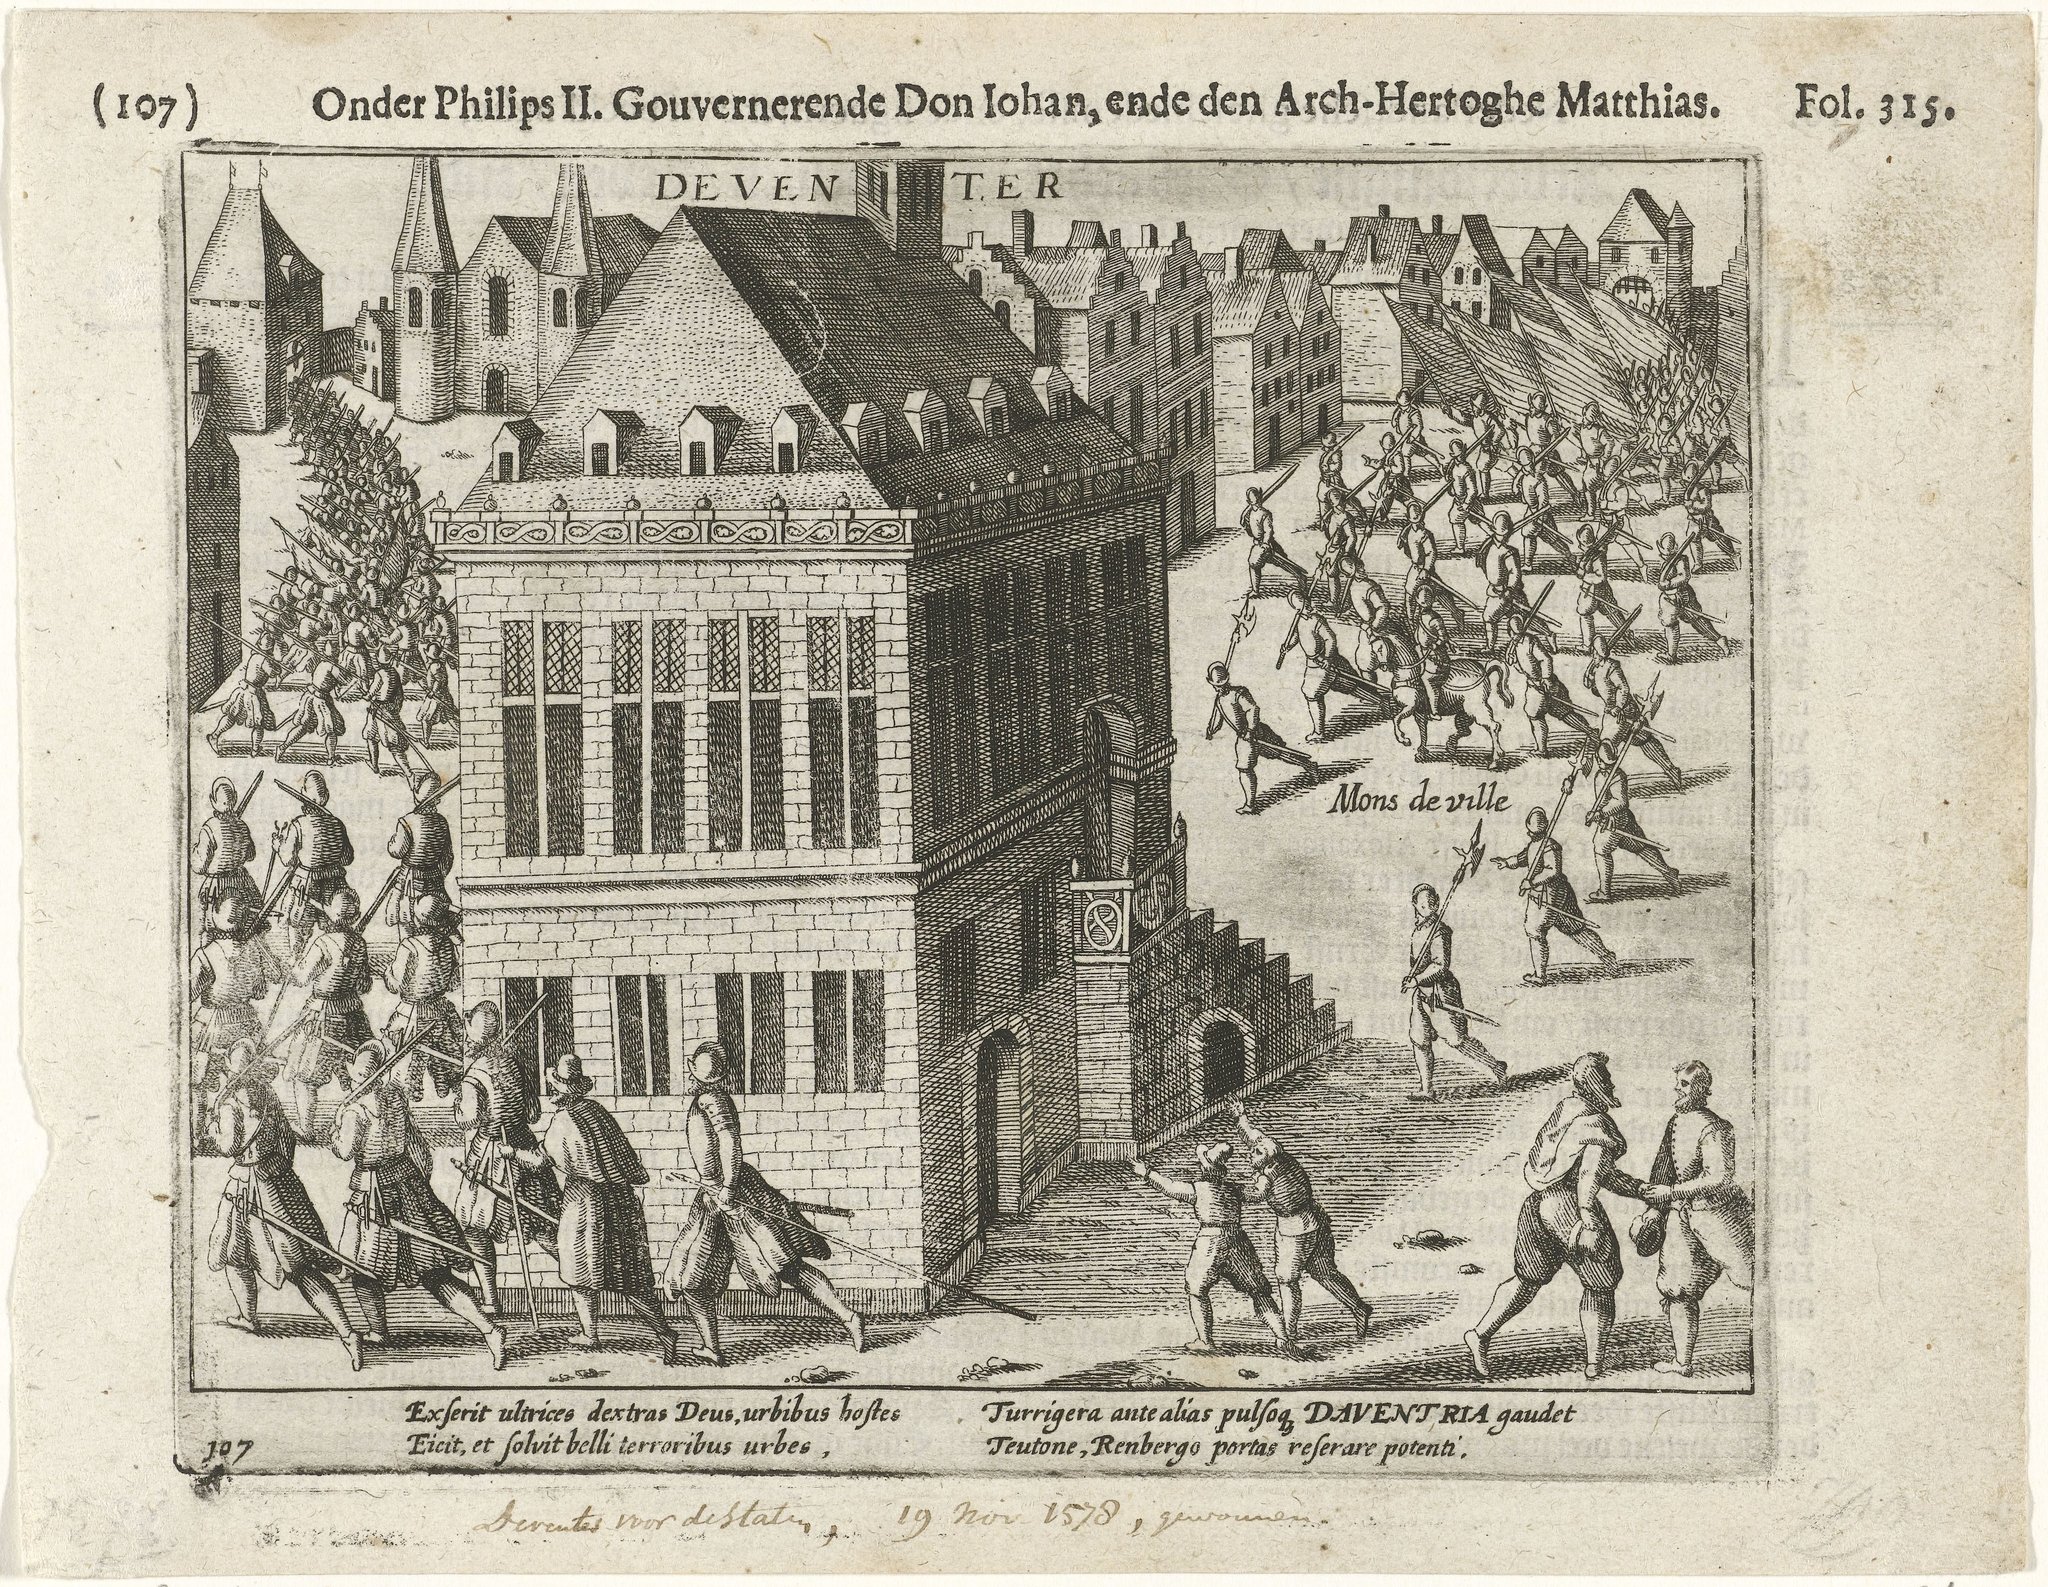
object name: history print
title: Deventer voor de Staten ingenomen, 1578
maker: Anonymous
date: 1613-1615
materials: paper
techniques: etching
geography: northern netherlands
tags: groningen (province), politician, capture of city (after the siege), deventer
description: Overgave van de stad Deventer na belegering door het Staatse leger onder de graaf van Rennenberg, 19 november 1578. Links de aftocht van het Duitse garnizoen. Met onderschrift van 4 regels in het Latijn. Genummerd: 107. Bedrukt op achterzijde met tekst in het Nederlands.